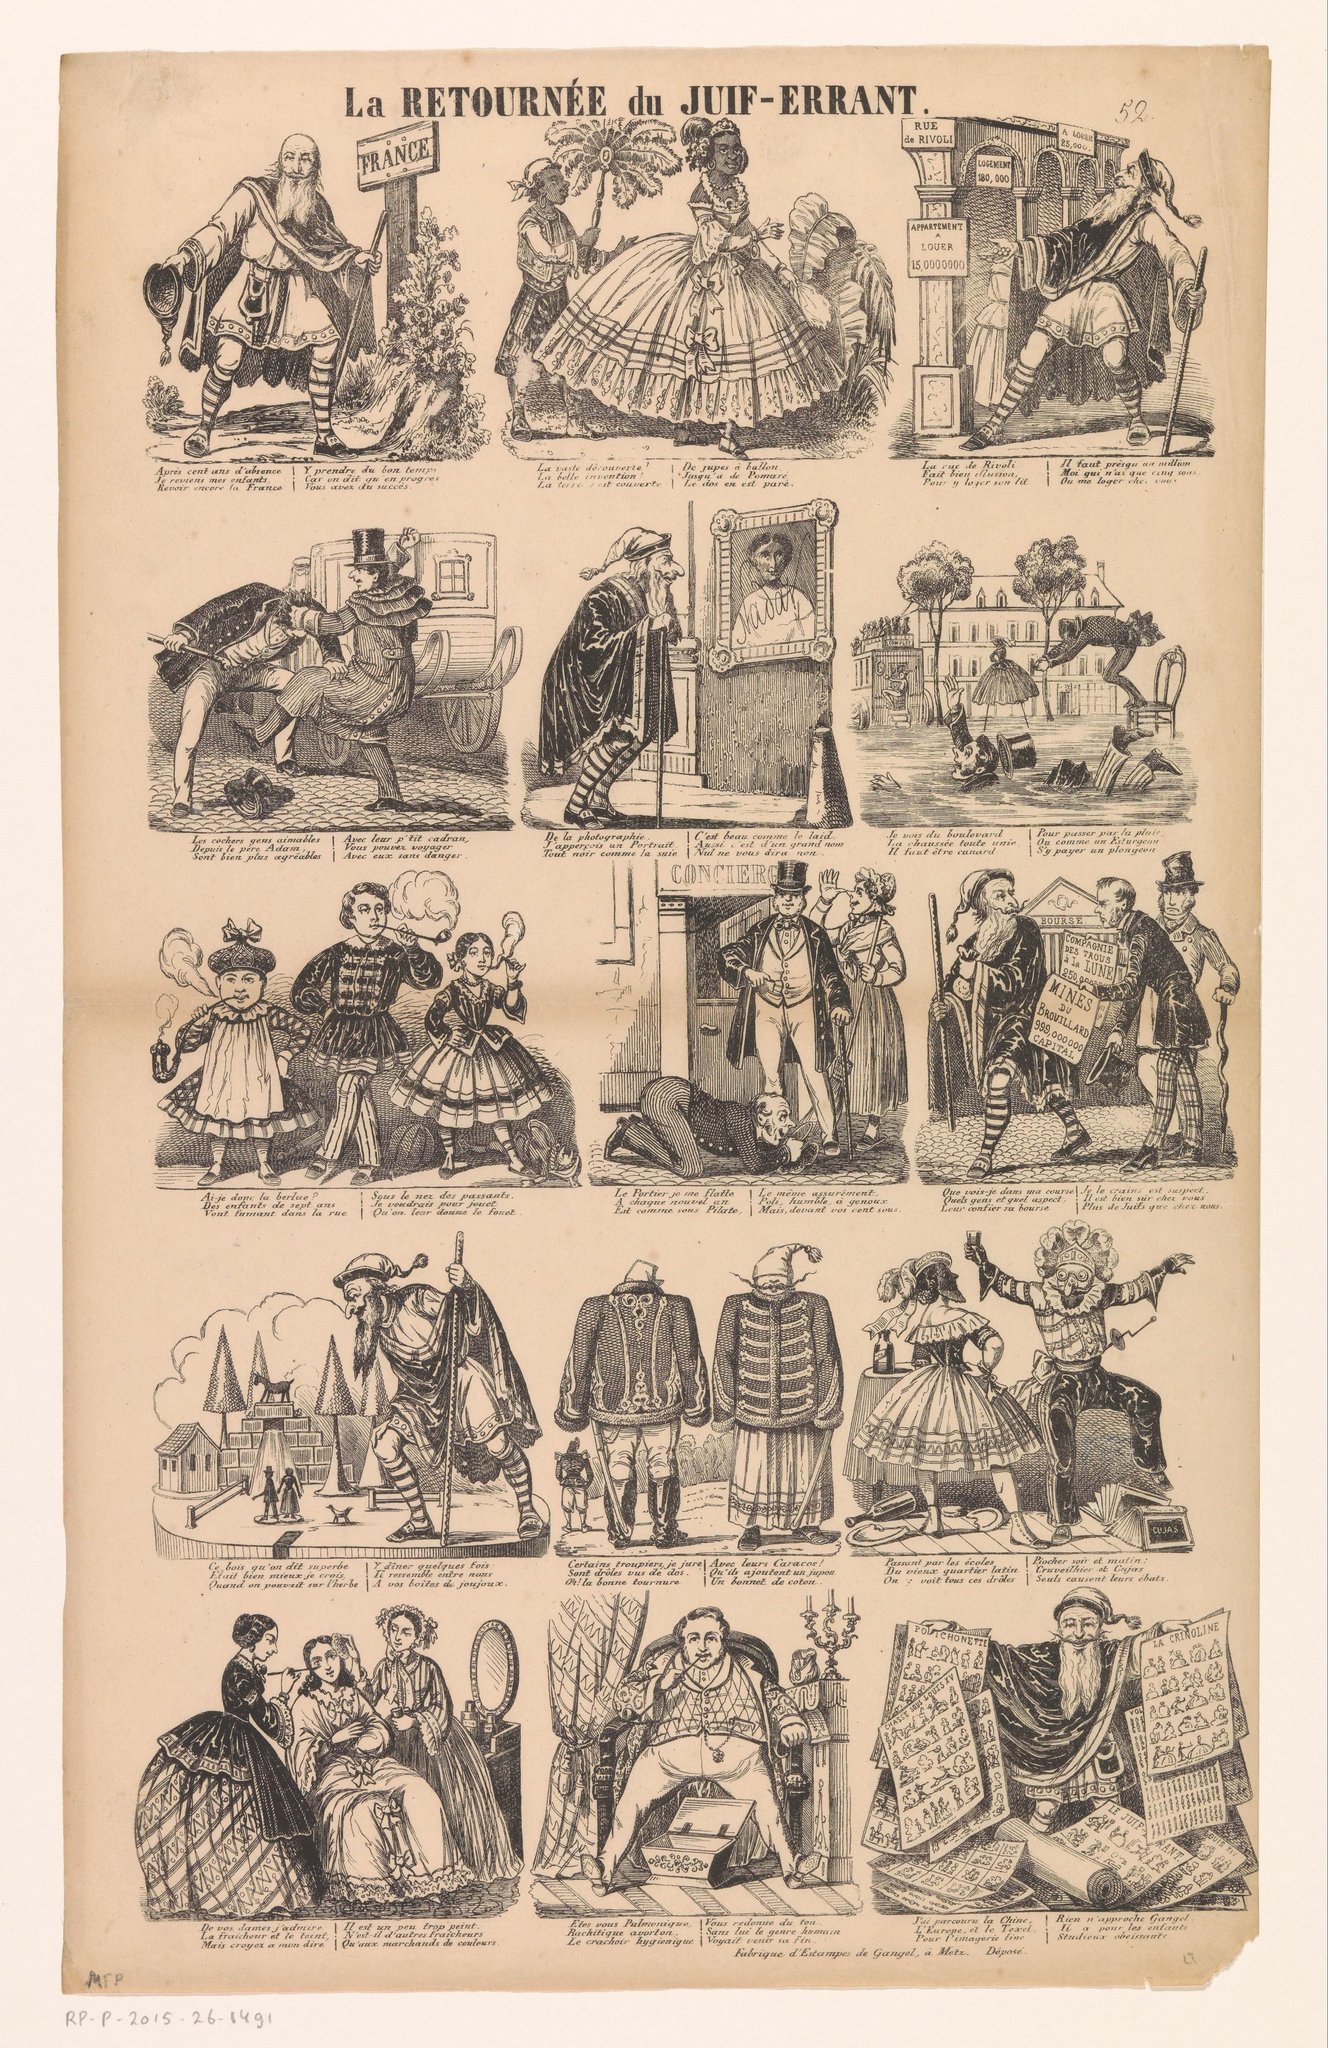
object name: print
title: Terugkeer van de wandelende jood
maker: gangel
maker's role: publisher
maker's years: -1879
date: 1840-1868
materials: paper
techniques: lithograph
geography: metz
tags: ahasverus, the wandering jew, photograph, print, e.g.: engraving, etching, lithograph, pipe ~ tobacco, paris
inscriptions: collector's mark: Lugt 4779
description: Vijftien scènes tonen de nieuwigheden die de wandelende jood in Frankrijk tegenkomt na honderd jaar afwezigheid. Hieronder bevinden zich onder meer een zwarte vrouw met een page, appartementen aan de Rue de Rivoli die voor woekerprijzen worden aangeboden, een foto gemaakt door Nadar, rokende kinderen en louche beurshandelaren. De laatste scène toont de wandelende jood omringd door prenten uitgegeven door Gangel. Rechtsboven genummerd: 52.